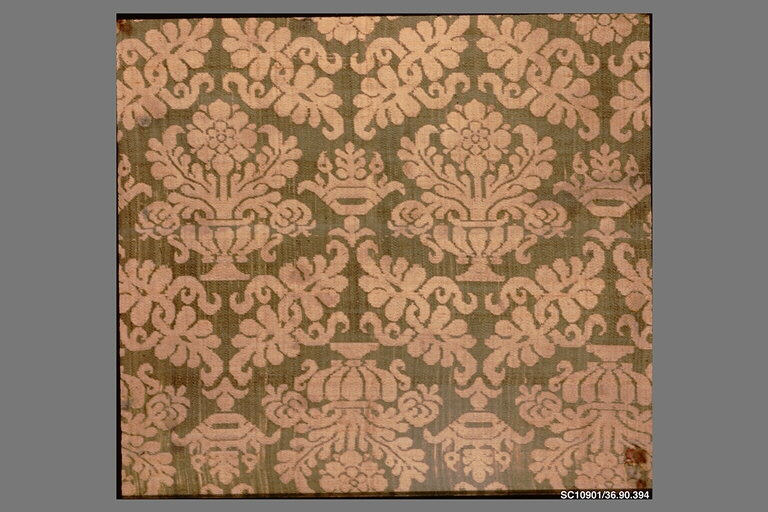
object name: piece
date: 1501-1700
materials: silk